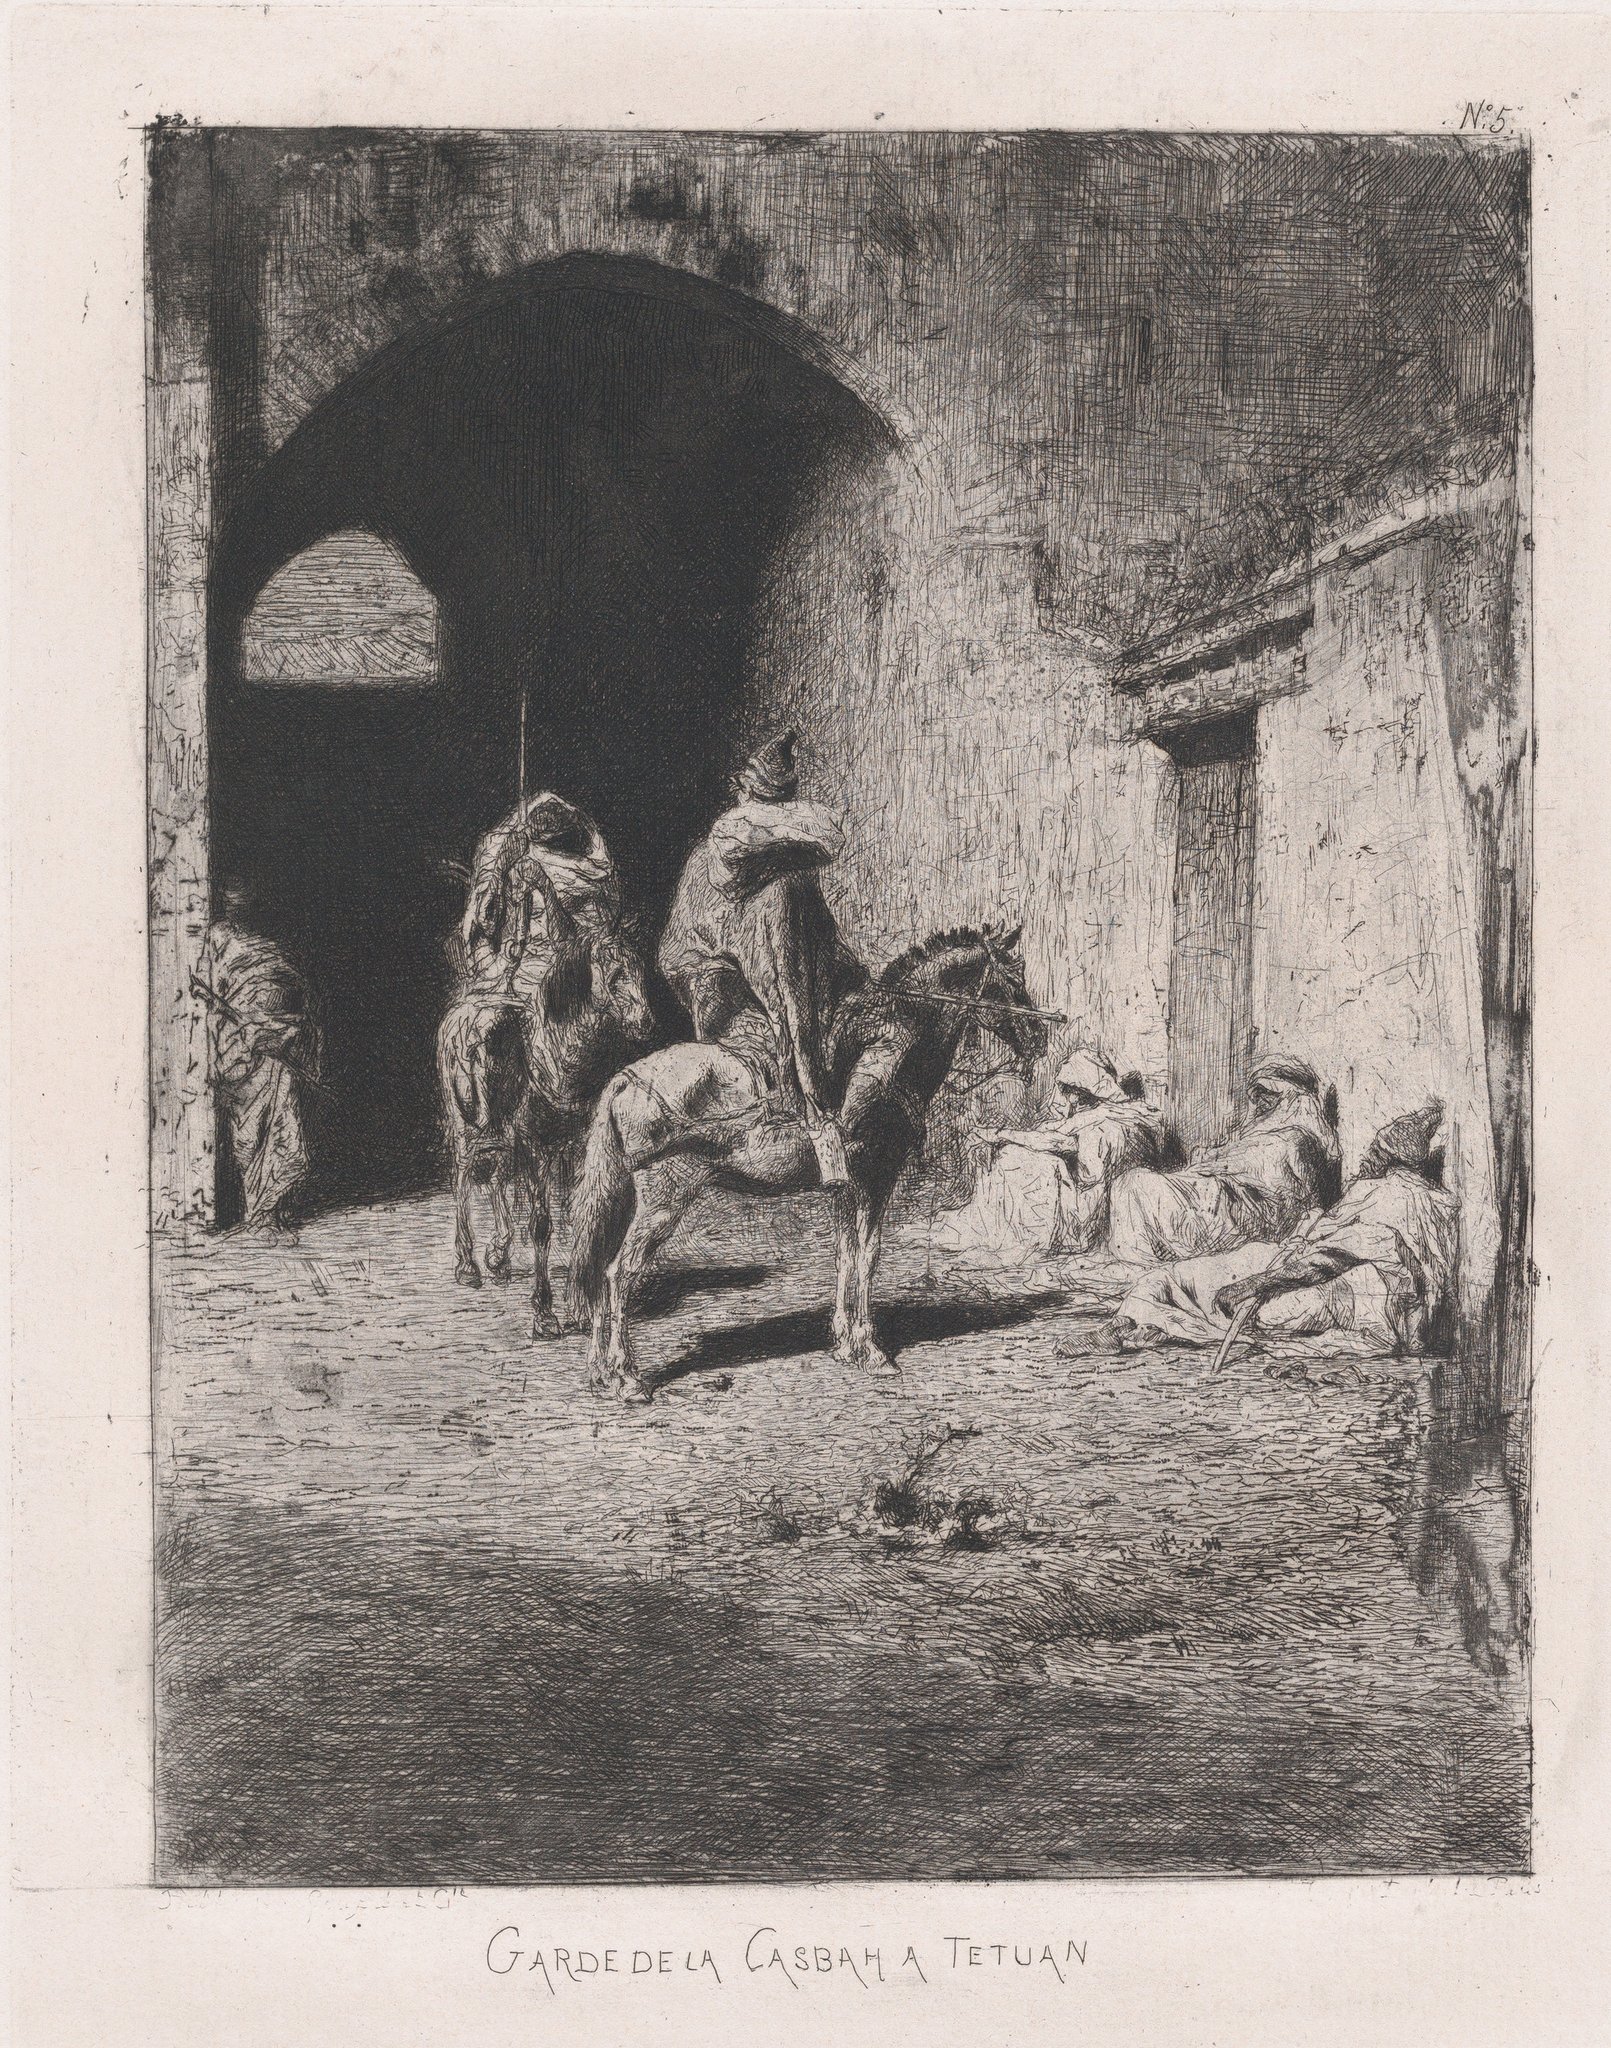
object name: print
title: Entrance to the Kasbah in Tetuan, figures sitting on the ground, others on horseback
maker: mariano fortuny, 1838–1874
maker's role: artist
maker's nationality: spanish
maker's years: 1838-1874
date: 1873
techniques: etching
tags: men,horses